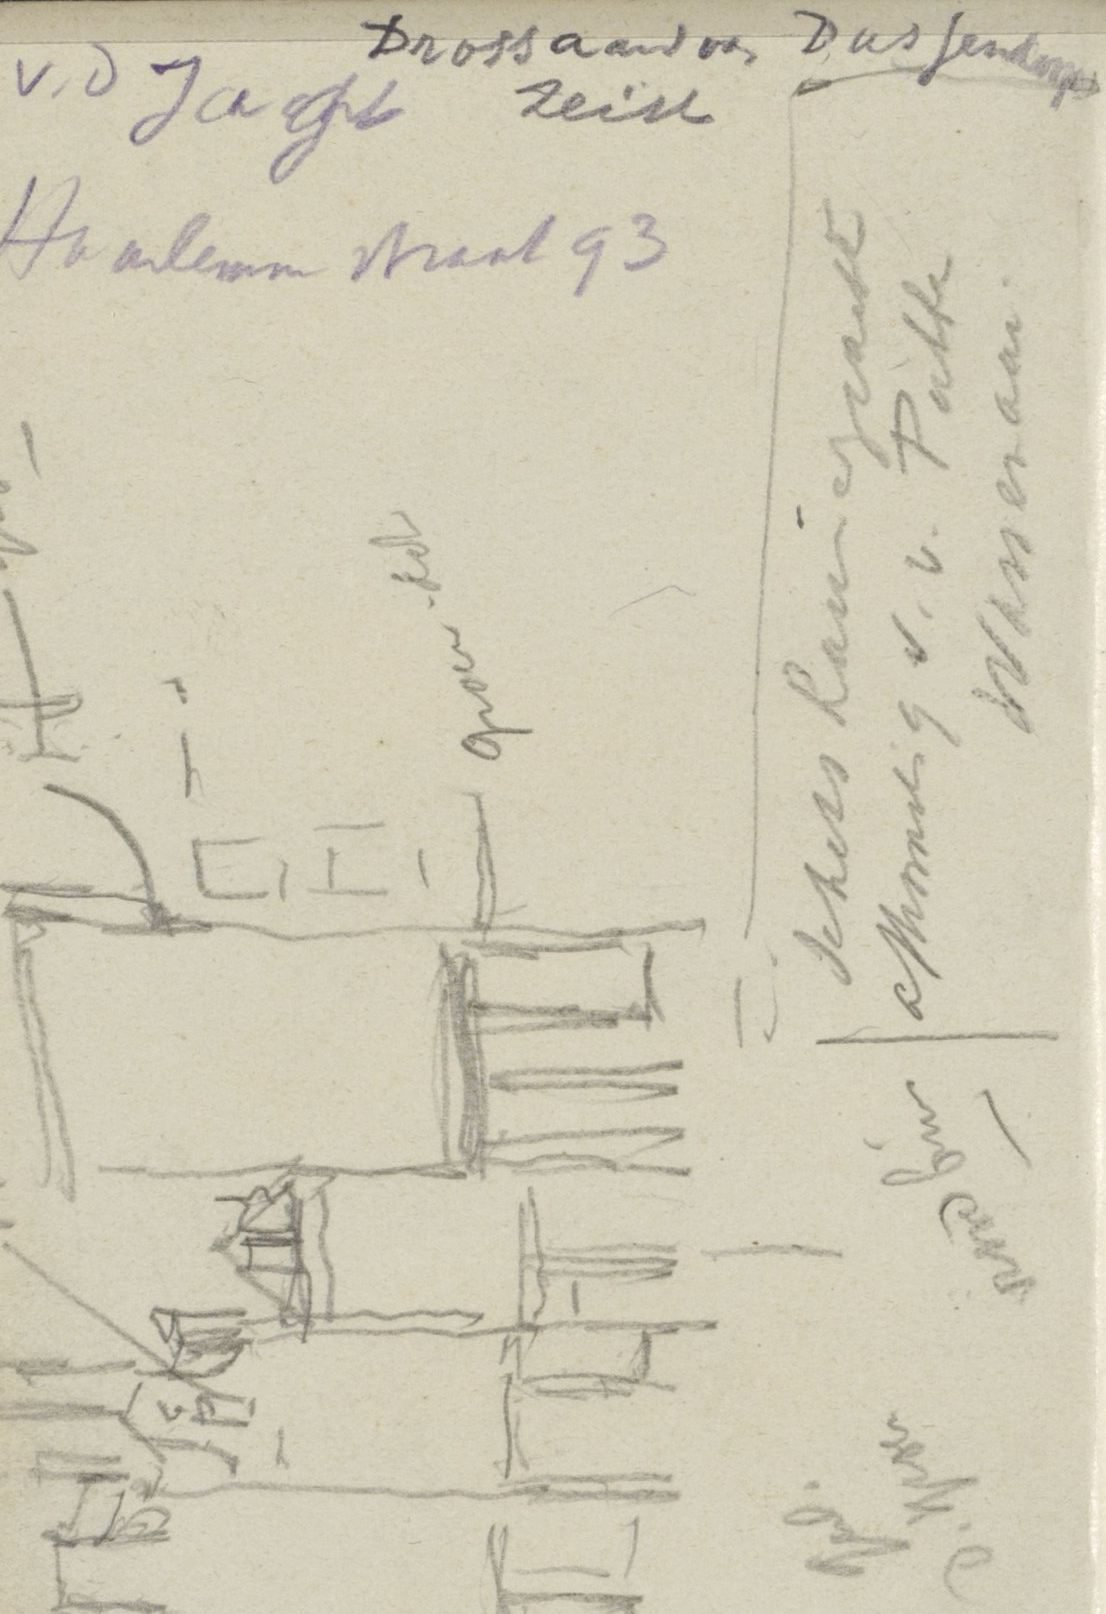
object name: sketchbook leaf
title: Gezicht op een rij gebouwen, mogelijk aan de Lauriergracht te Amsterdam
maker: george hendrik breitner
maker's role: draughtsman, painter, print maker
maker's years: 1857-1923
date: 1915-1916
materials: paper, pencil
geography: amsterdam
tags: civic architecture; edifices; dwellings, street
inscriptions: annotation: ‘Drossaard van Dusseldorp/ v.d Jaght Zeist/ Haarlemm. straat 93/ Schets Lauriergracht/ afkomstig v. v. Patte[?]/ Wassenaar’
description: Pagina 3 uit een schetsboek met 43 bladen.